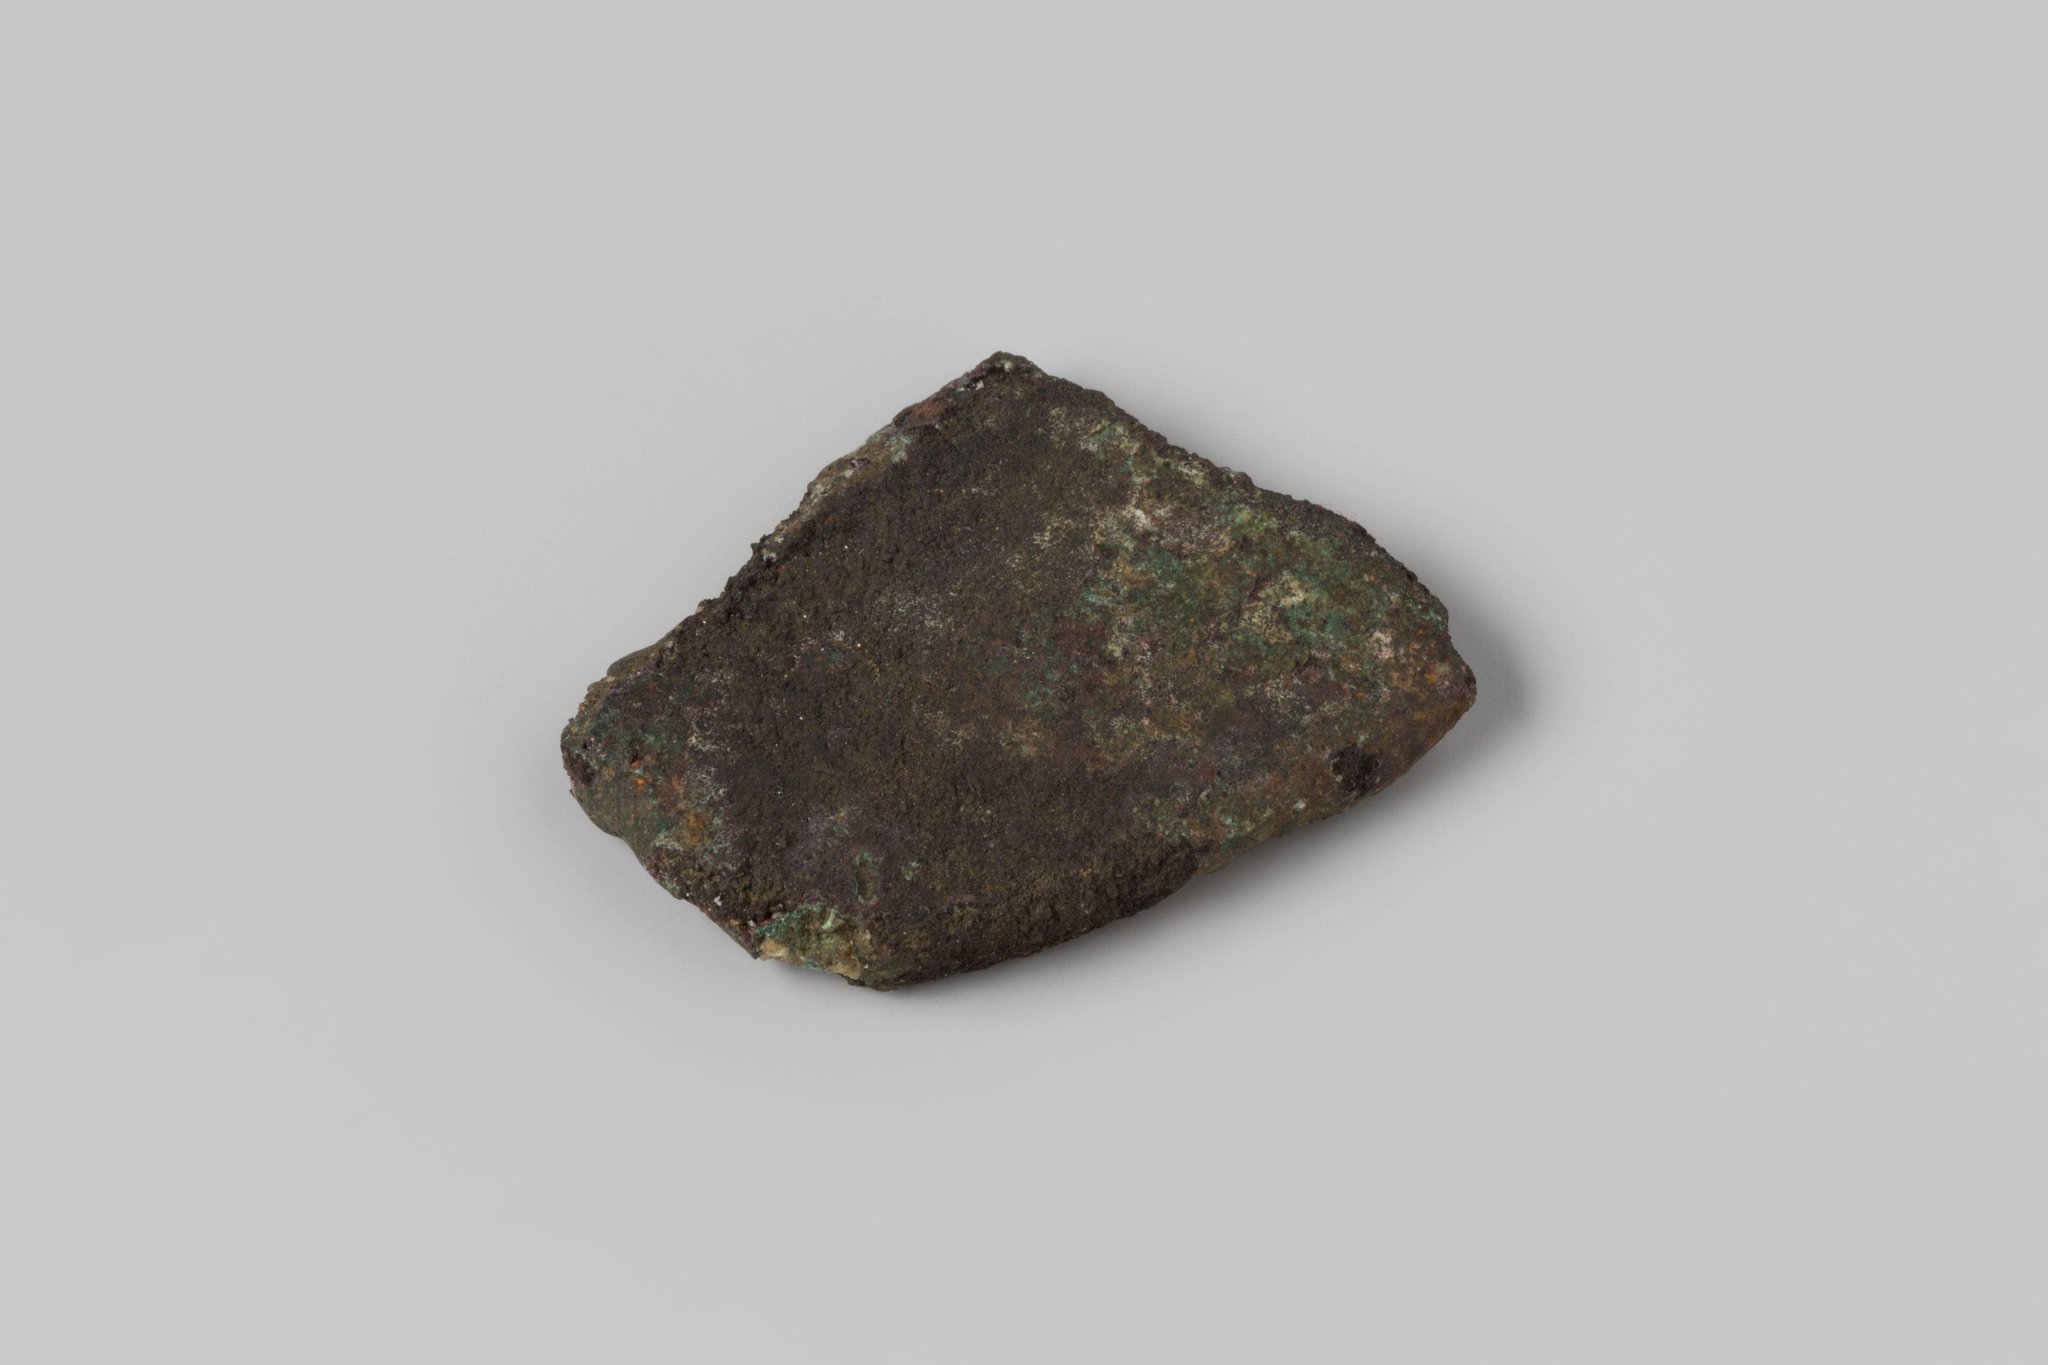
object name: scheepswrakvondst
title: Fragment van koper uit het wrak van de Oost-Indiëvaarder Hollandia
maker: Anonymous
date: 1700-1743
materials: copper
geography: netherlands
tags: verenigde oostindische compagnie, hollandia (schip), annet